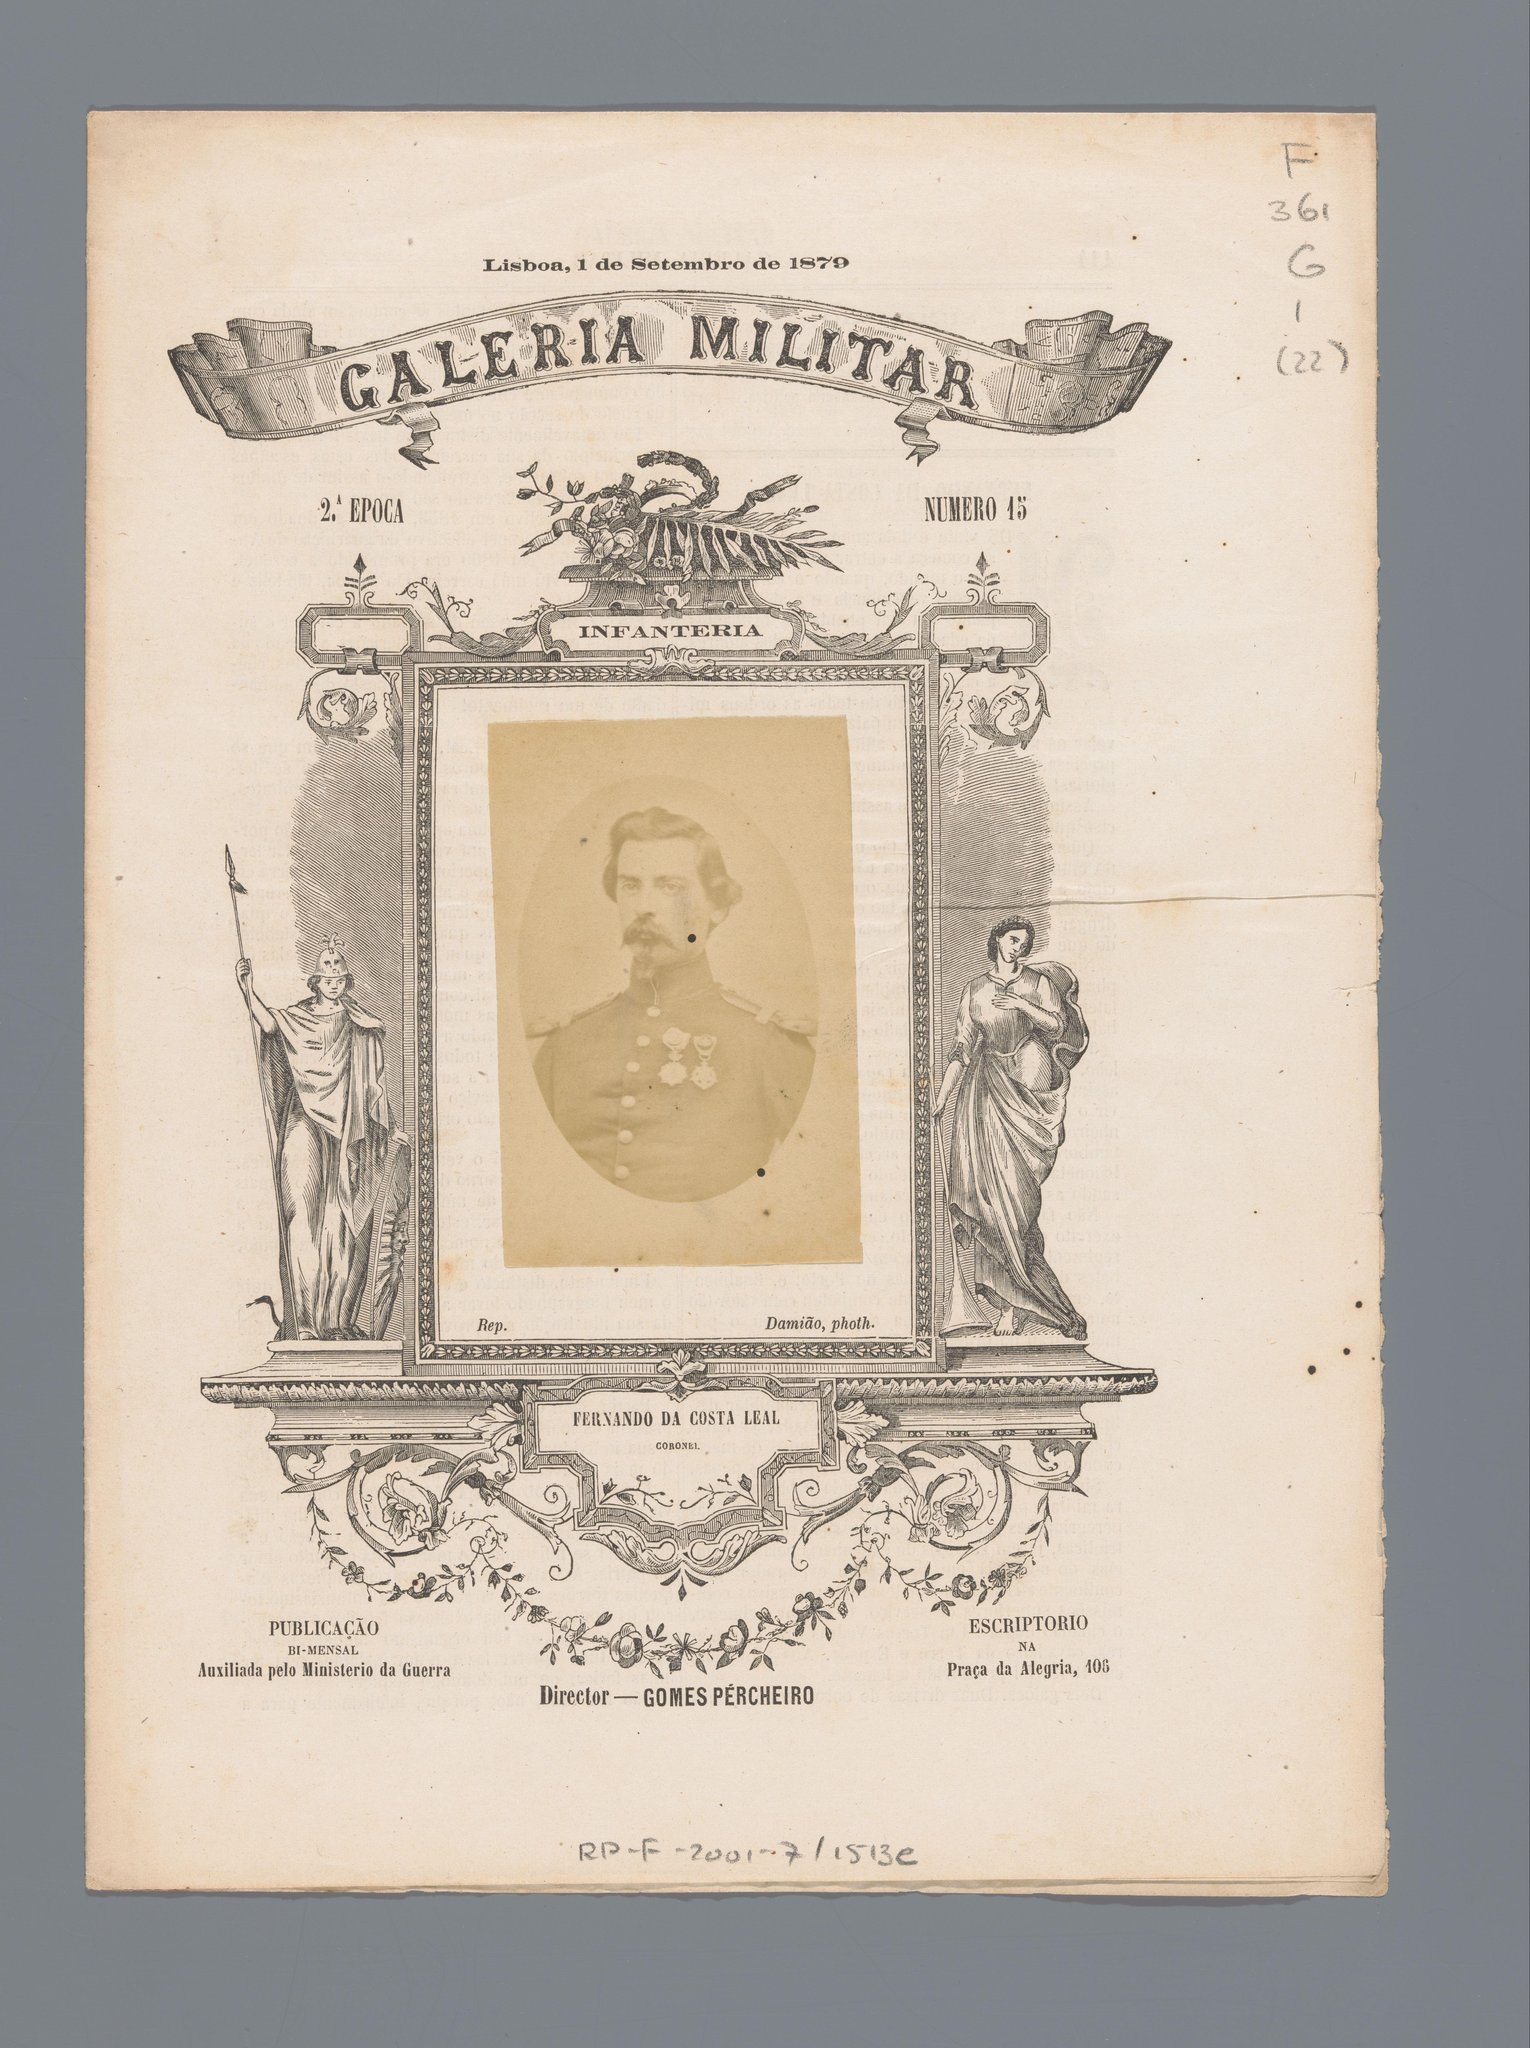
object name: book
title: Galeria militar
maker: gomes pércheiro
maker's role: publisher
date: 1879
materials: paper, photographic support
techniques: albumen print, printing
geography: lisbon